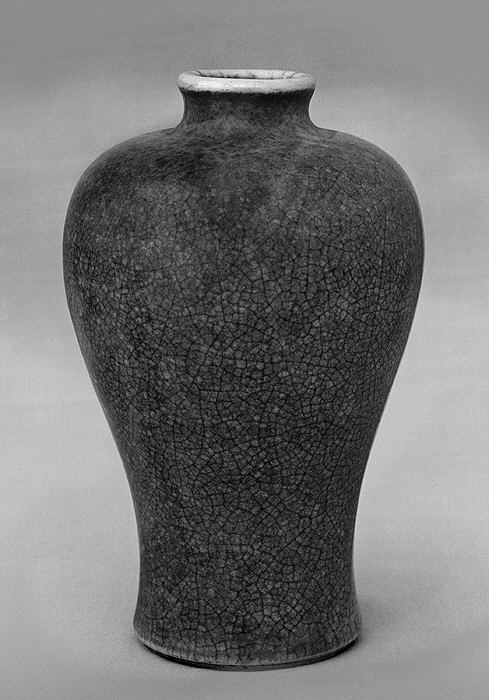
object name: vase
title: Prunus Vase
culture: chinese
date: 1622-1722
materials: porcelain